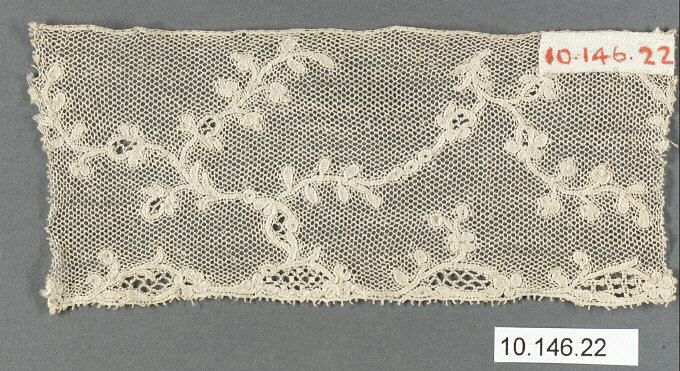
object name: fragment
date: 1701-1800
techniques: lace